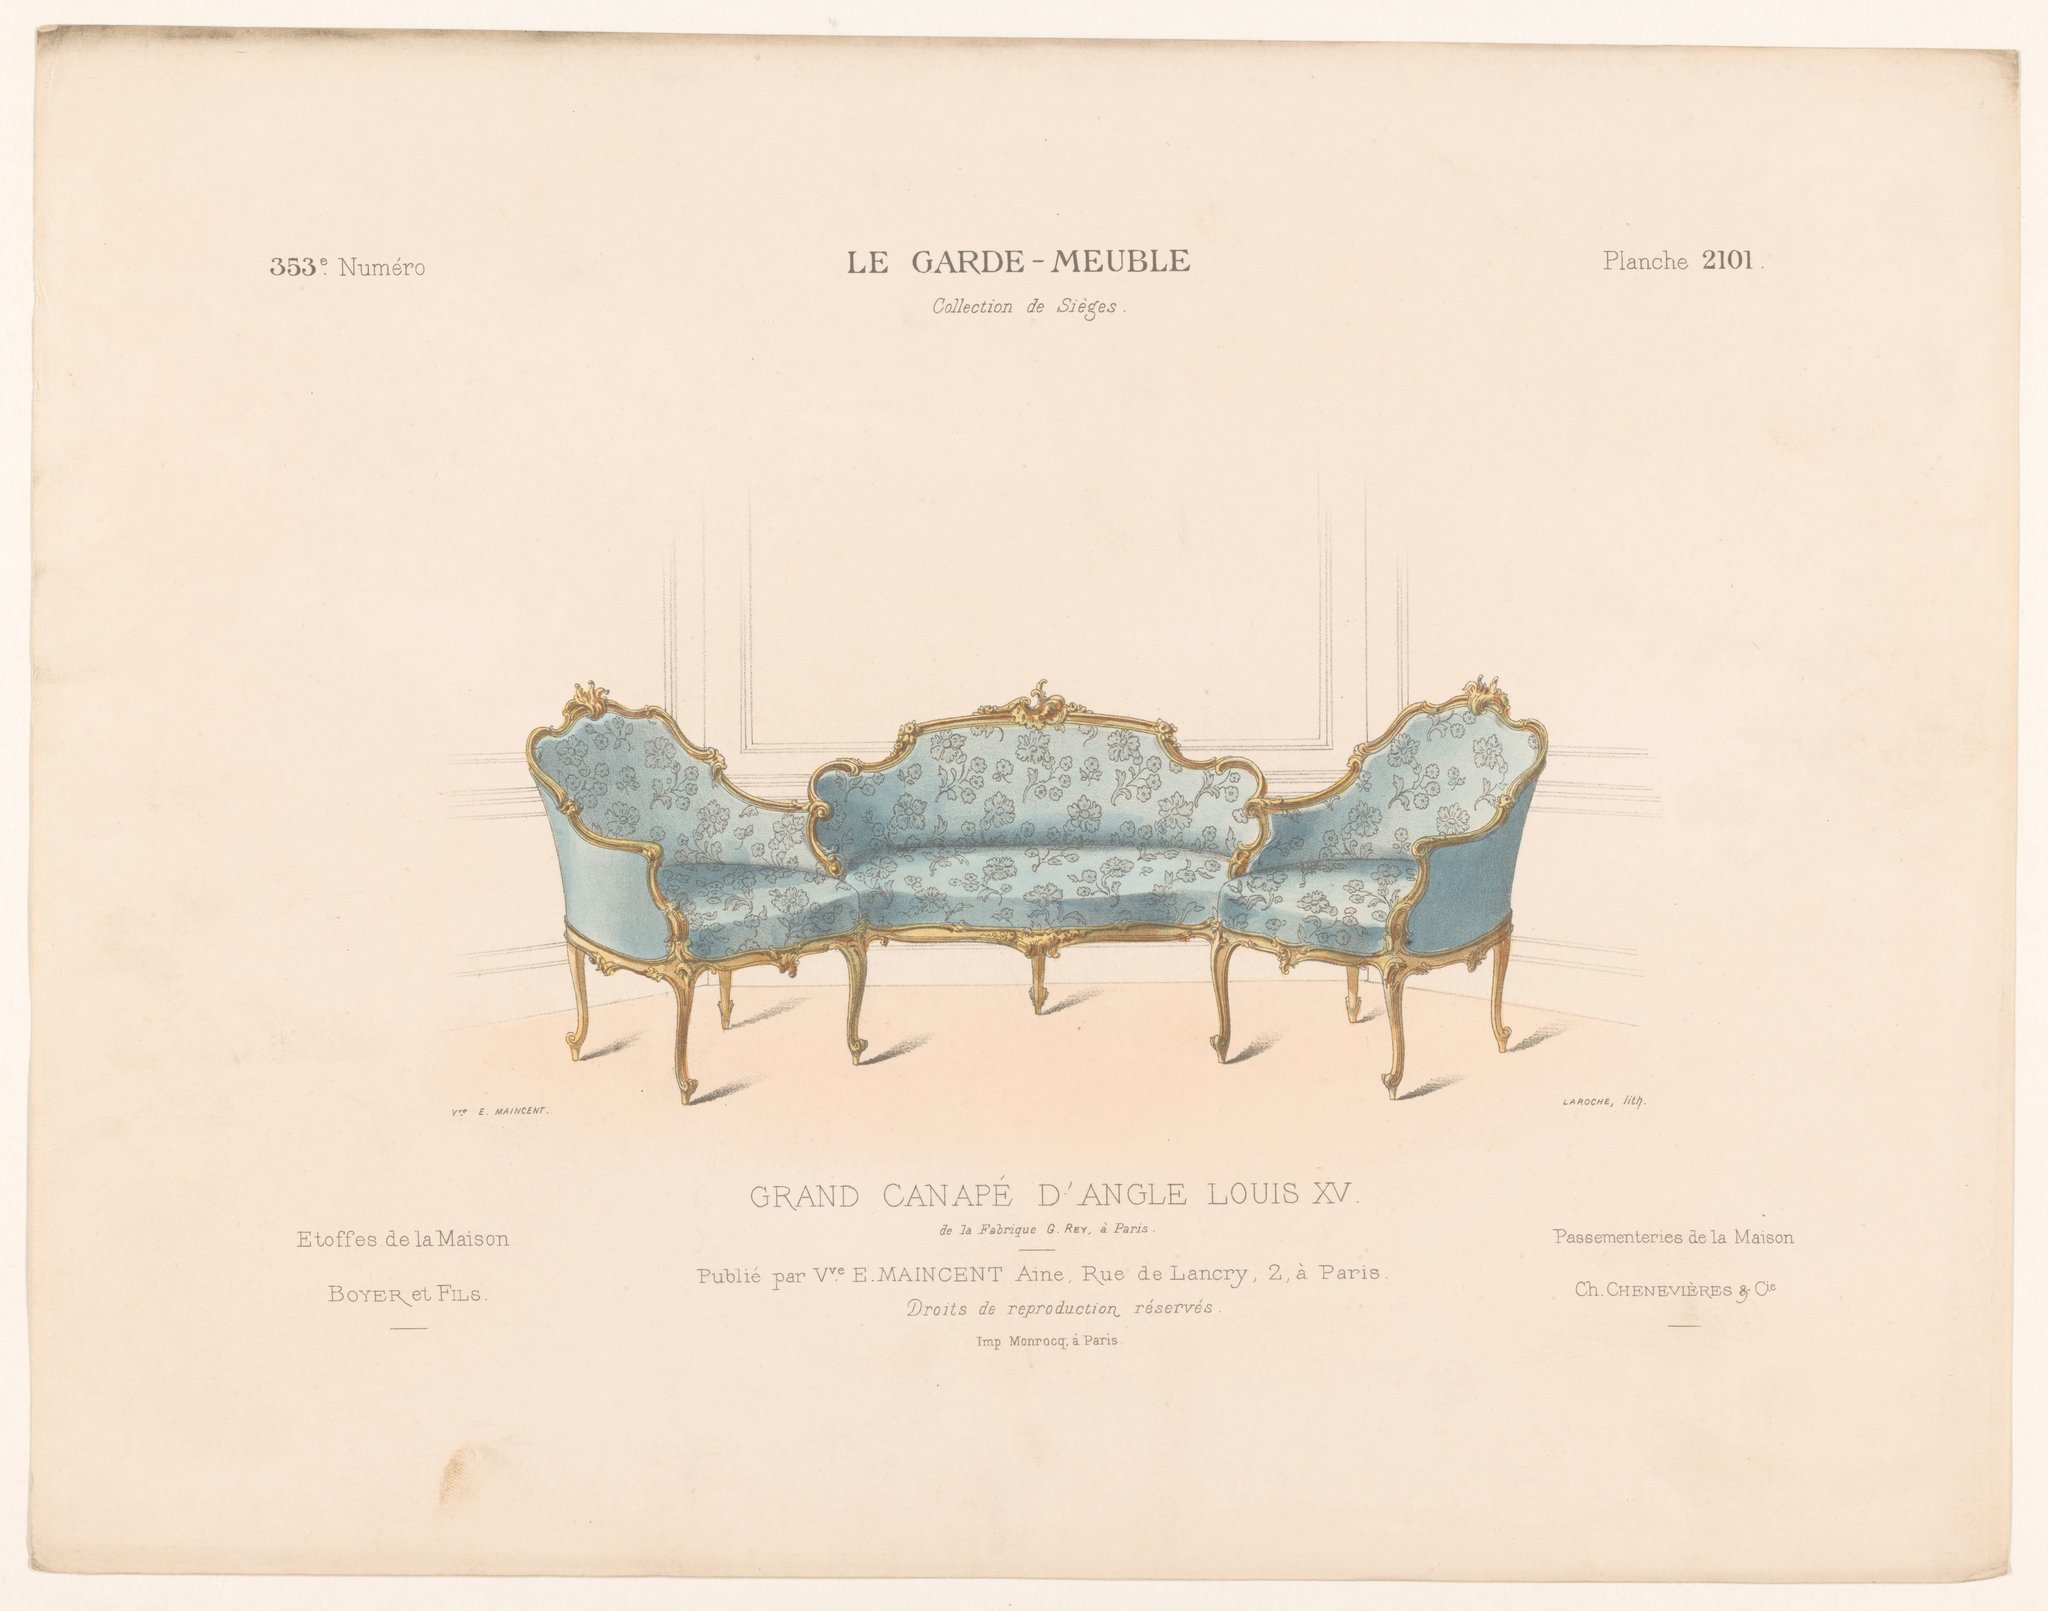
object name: print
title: Grand canapé d'angle Louis XV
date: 1895-1935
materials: paper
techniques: hand coloring, lithograph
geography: paris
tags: seating furniture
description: Ieder Livraison in de serie Le Garde-Meuble bevat negen platen: drie 'sièges' (zitmeubels), drie 'meubles' (diverse meubels zoals tafels en kasten) en drie 'tentures' (gordijnen en draperieën).